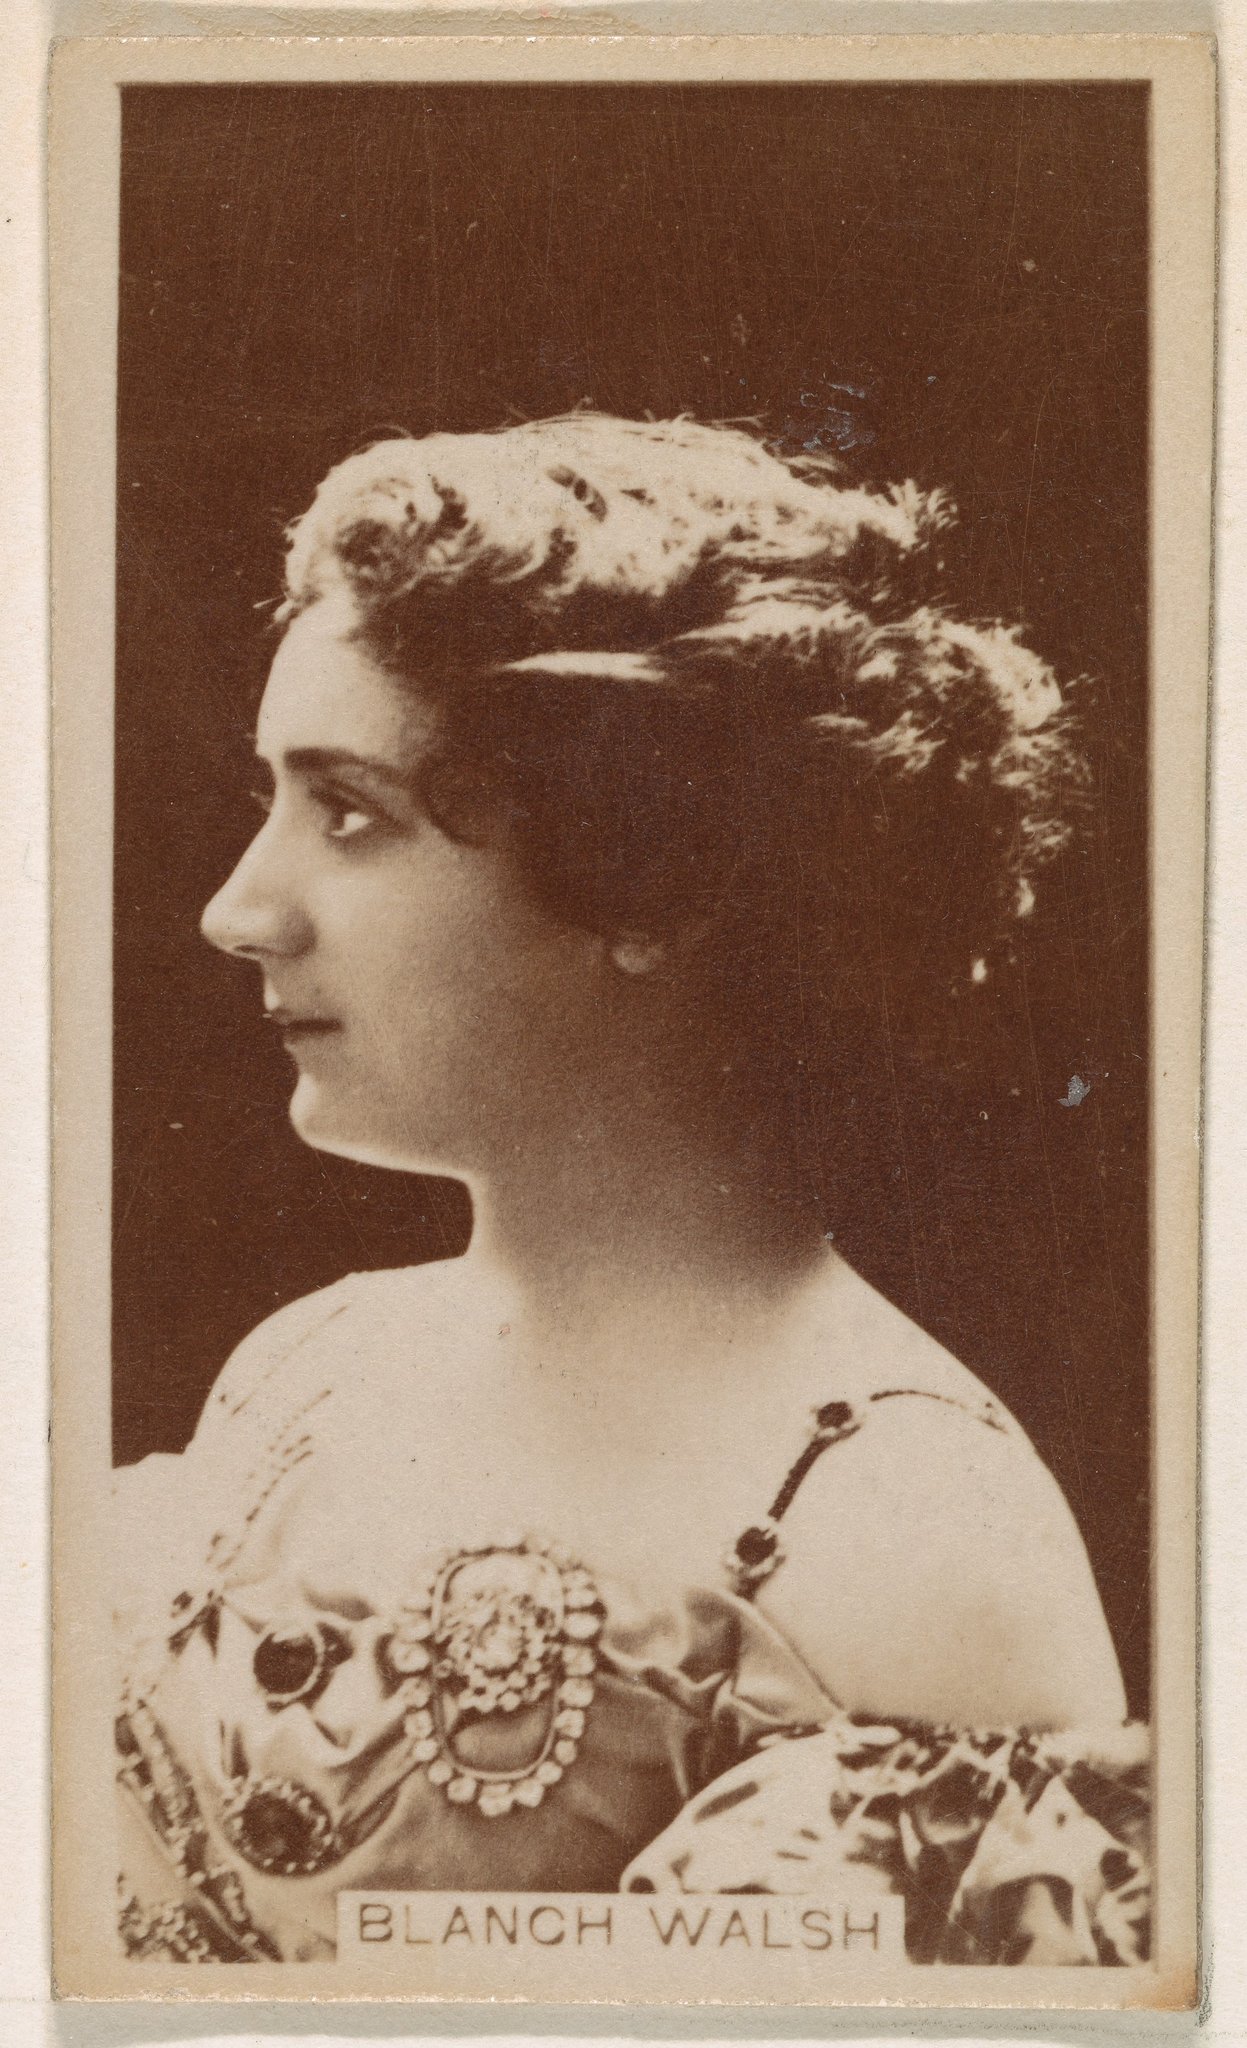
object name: photograph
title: Blanch Walsh, from the Actresses series (N245) issued by Kinney Brothers to promote Sweet Caporal Cigarettes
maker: kinney brothers tobacco company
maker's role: publisher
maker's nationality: american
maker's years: 1869-2011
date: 1890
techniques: albumen silver print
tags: profiles,women,actresses